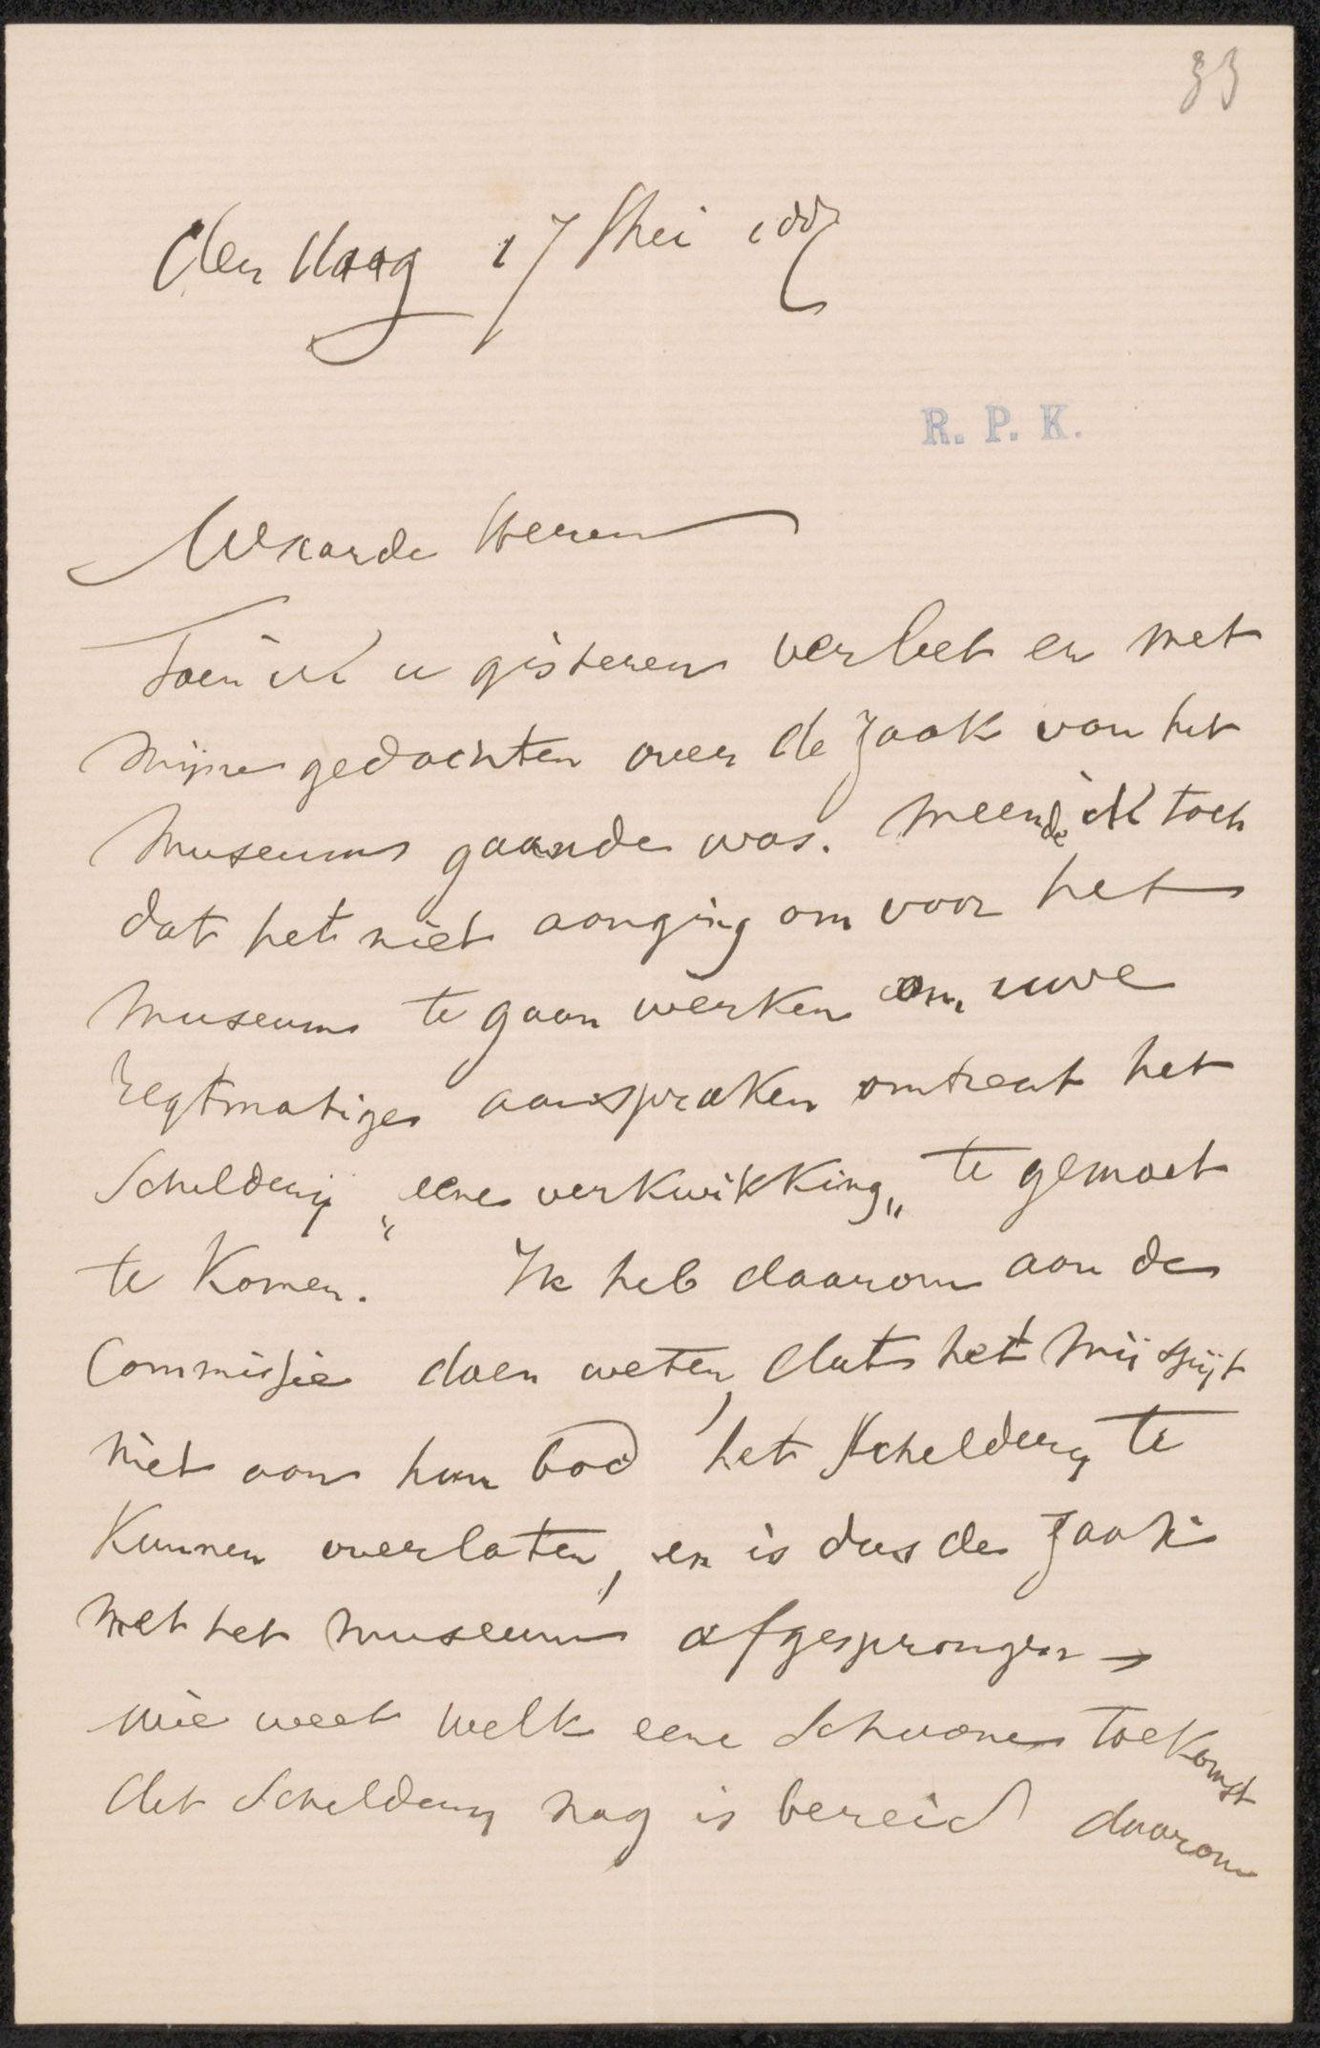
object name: letter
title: Brief aan Frans Buffa en Zonen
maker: jozef israëls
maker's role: draughtsman, painter, print maker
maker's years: 1824-1911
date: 1887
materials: ink, paper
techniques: pen, writing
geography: the hague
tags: publisher, painting (including book-illumination, miniature-painting), paris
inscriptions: collector's mark: Lugt 2233